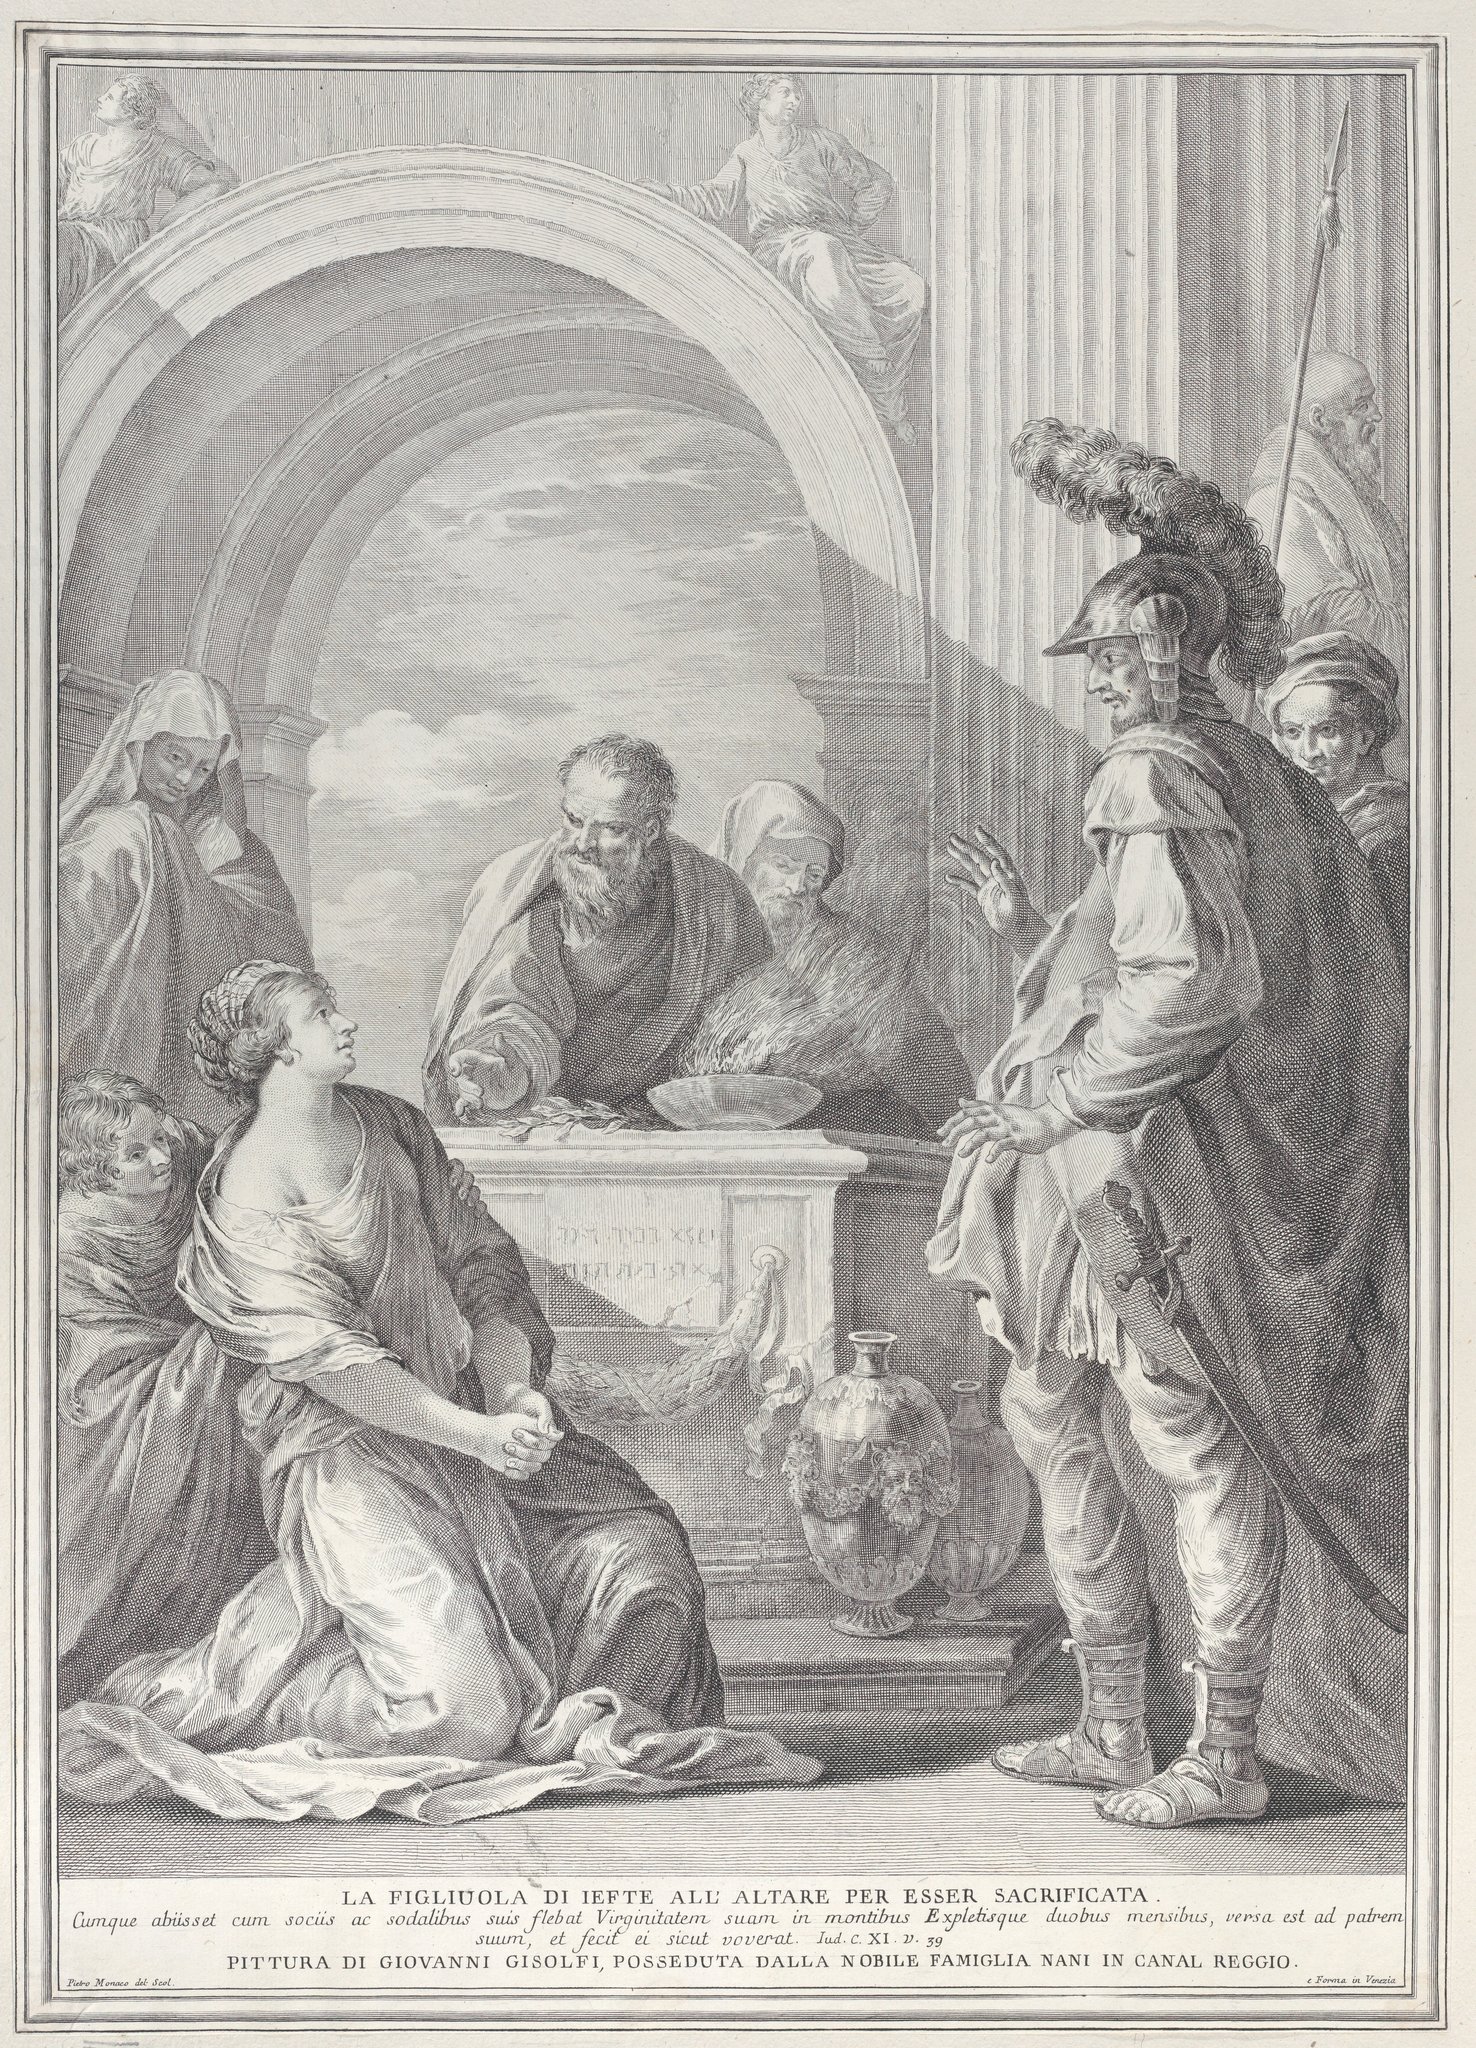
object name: print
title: Jephthah's daughter kneeling by the sacrificial altar, with her father standing at right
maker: pietro monaco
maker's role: artist and publisher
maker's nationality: italian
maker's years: 1707-1772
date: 1730-1750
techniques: engraving, etching